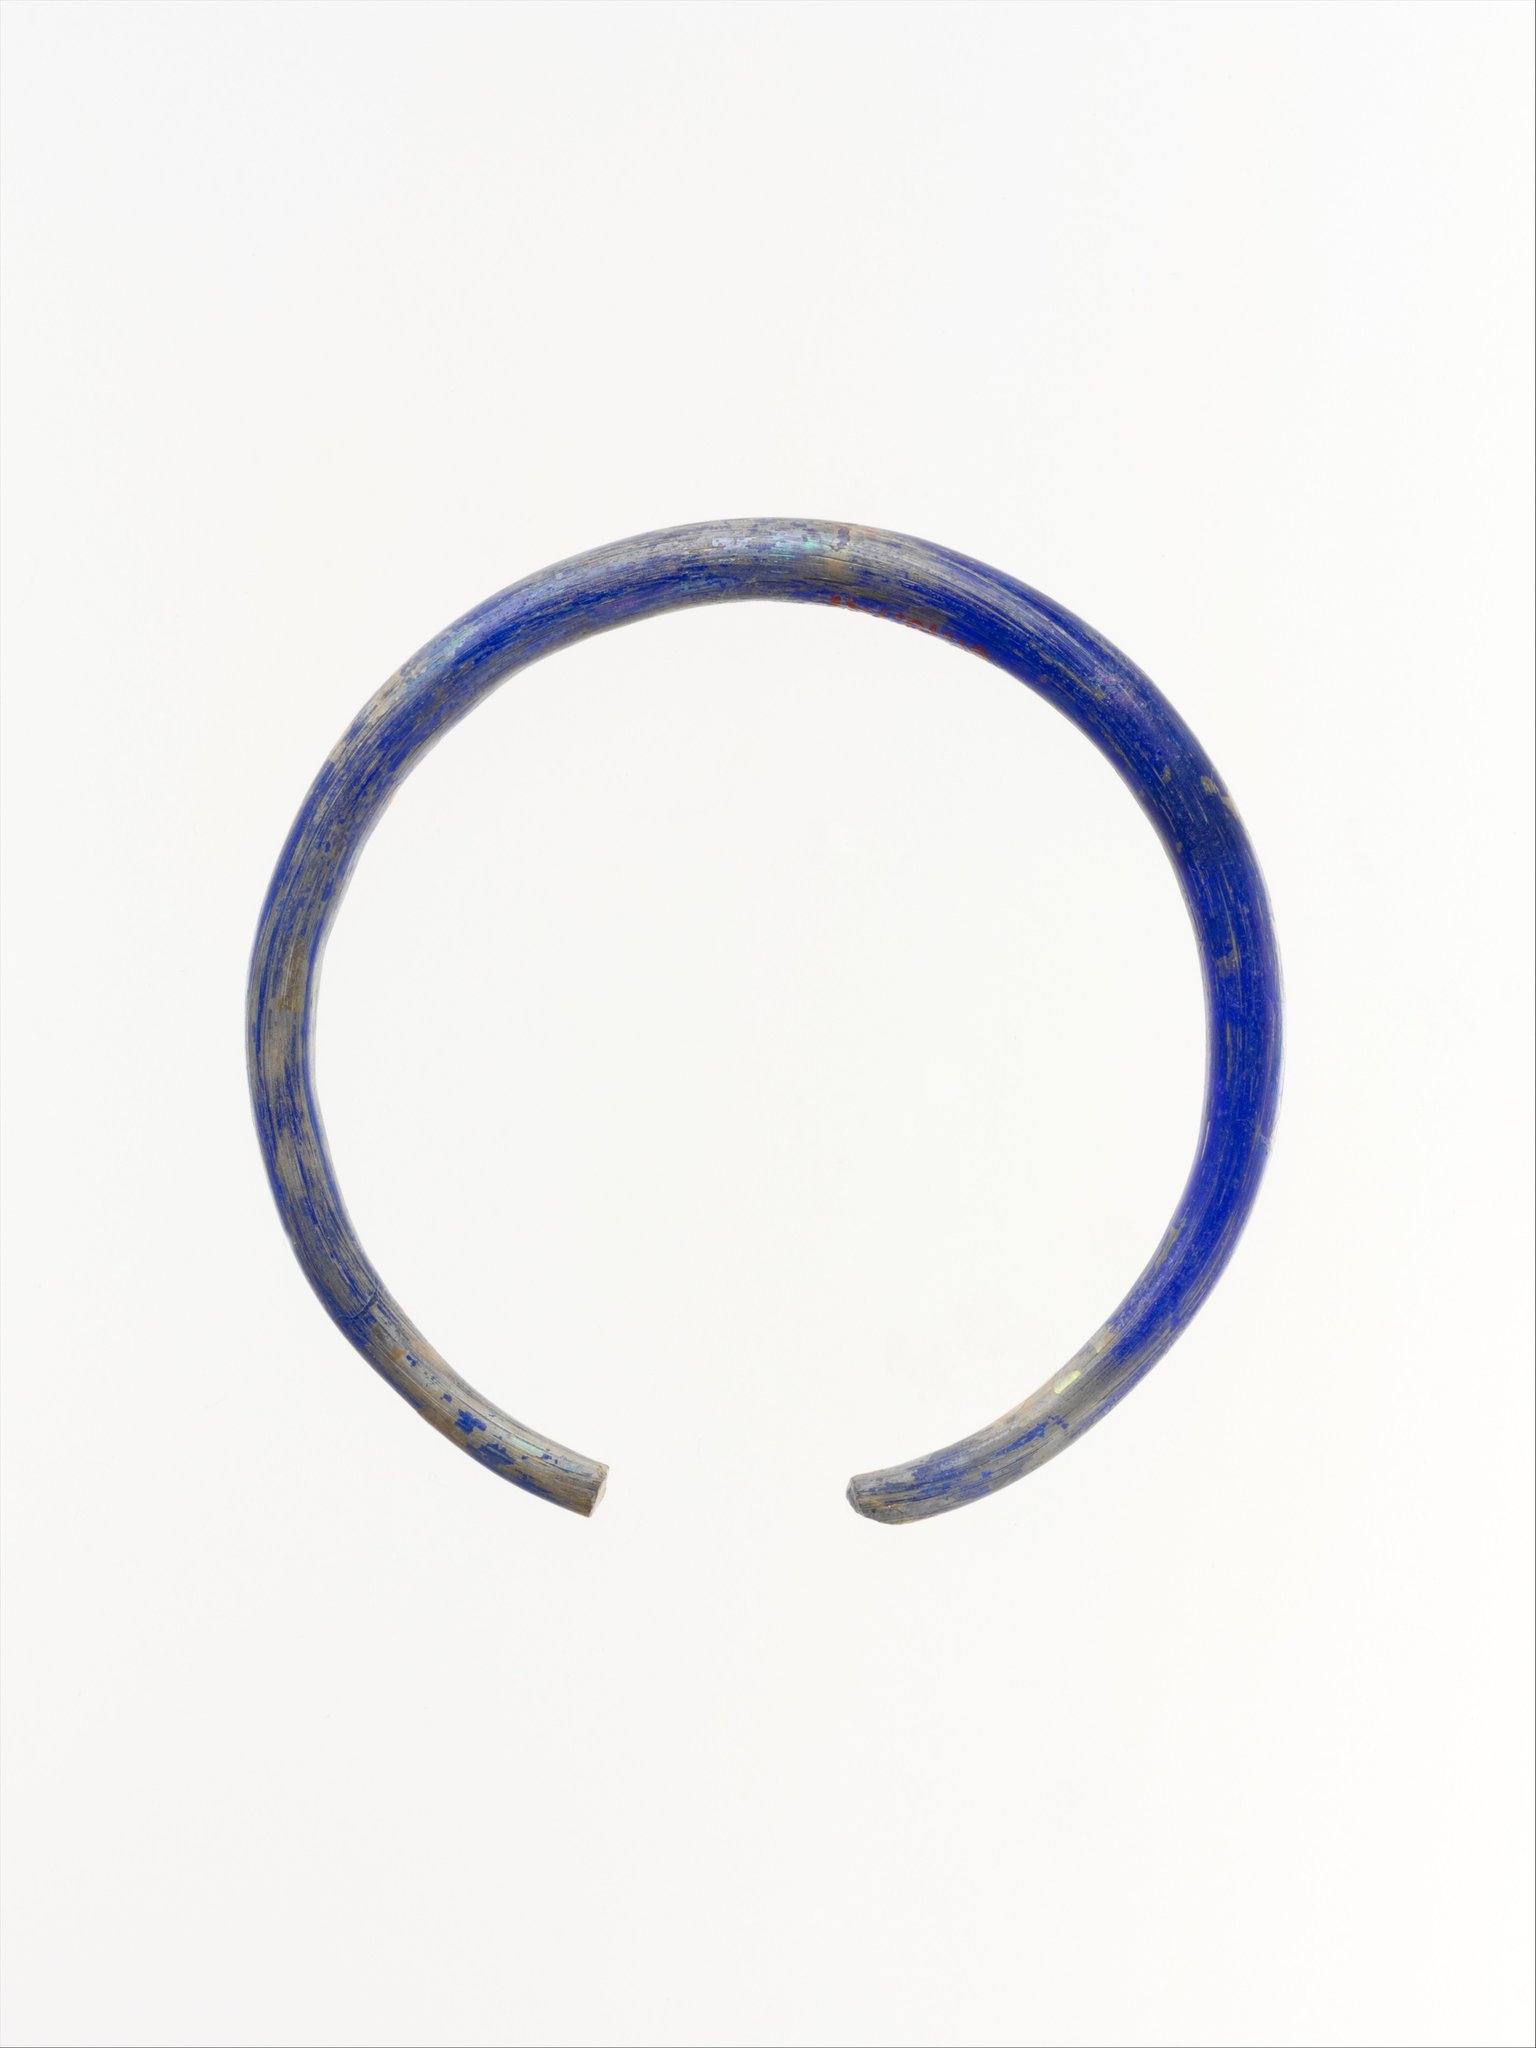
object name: bracelet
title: Glass bracelet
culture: greek or lydian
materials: glass